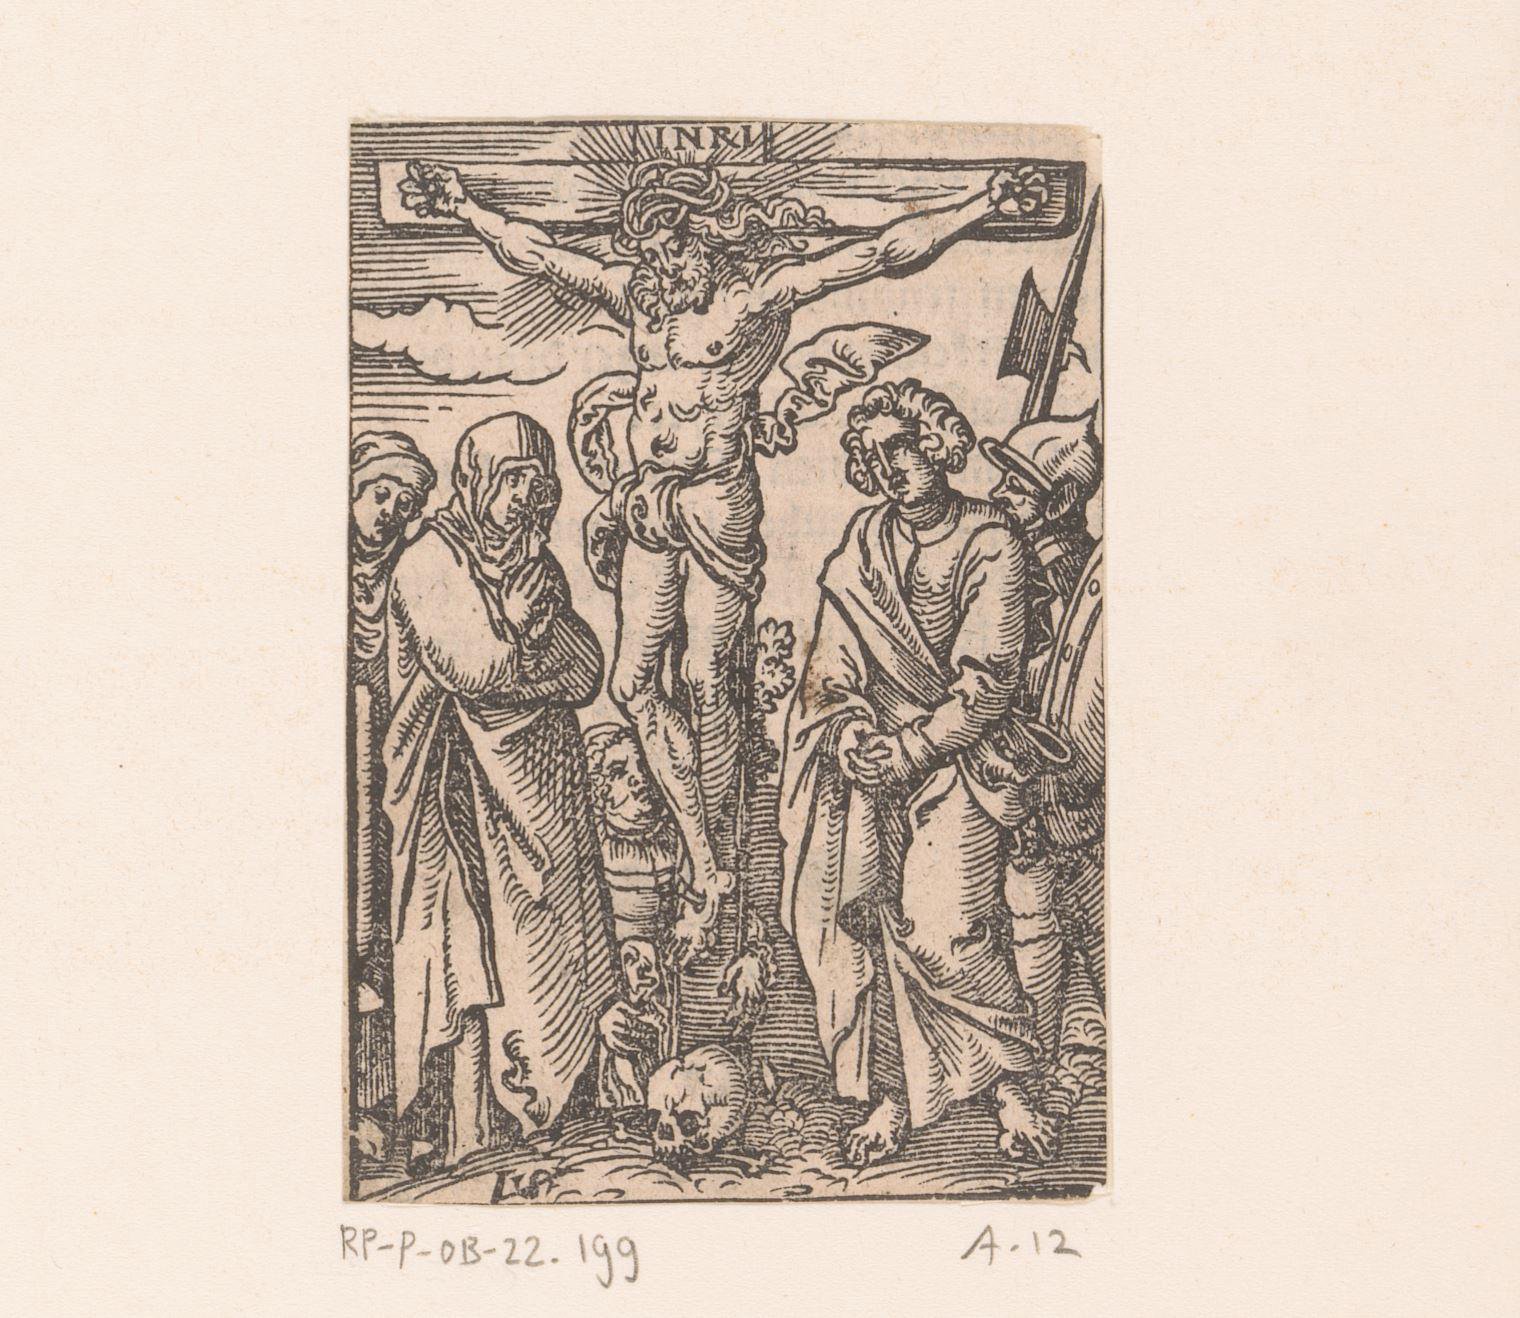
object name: book illustration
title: Kruisiging van Christus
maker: virgilius solis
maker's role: draughtsman, print maker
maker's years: 1514-1562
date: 1558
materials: paper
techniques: woodcut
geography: nuremberg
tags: the crucifixion of christ: prelude to christ's death on the cross (matthew 27:34-44; mark 15:23-32; luke 23:33-43; john 19:18-24)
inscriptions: number: ‘180’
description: Gebruikt voor de publicatie: Rhau, Georg. Hortulus Animae. Neurenberg: Valentin Geißler, 1558.